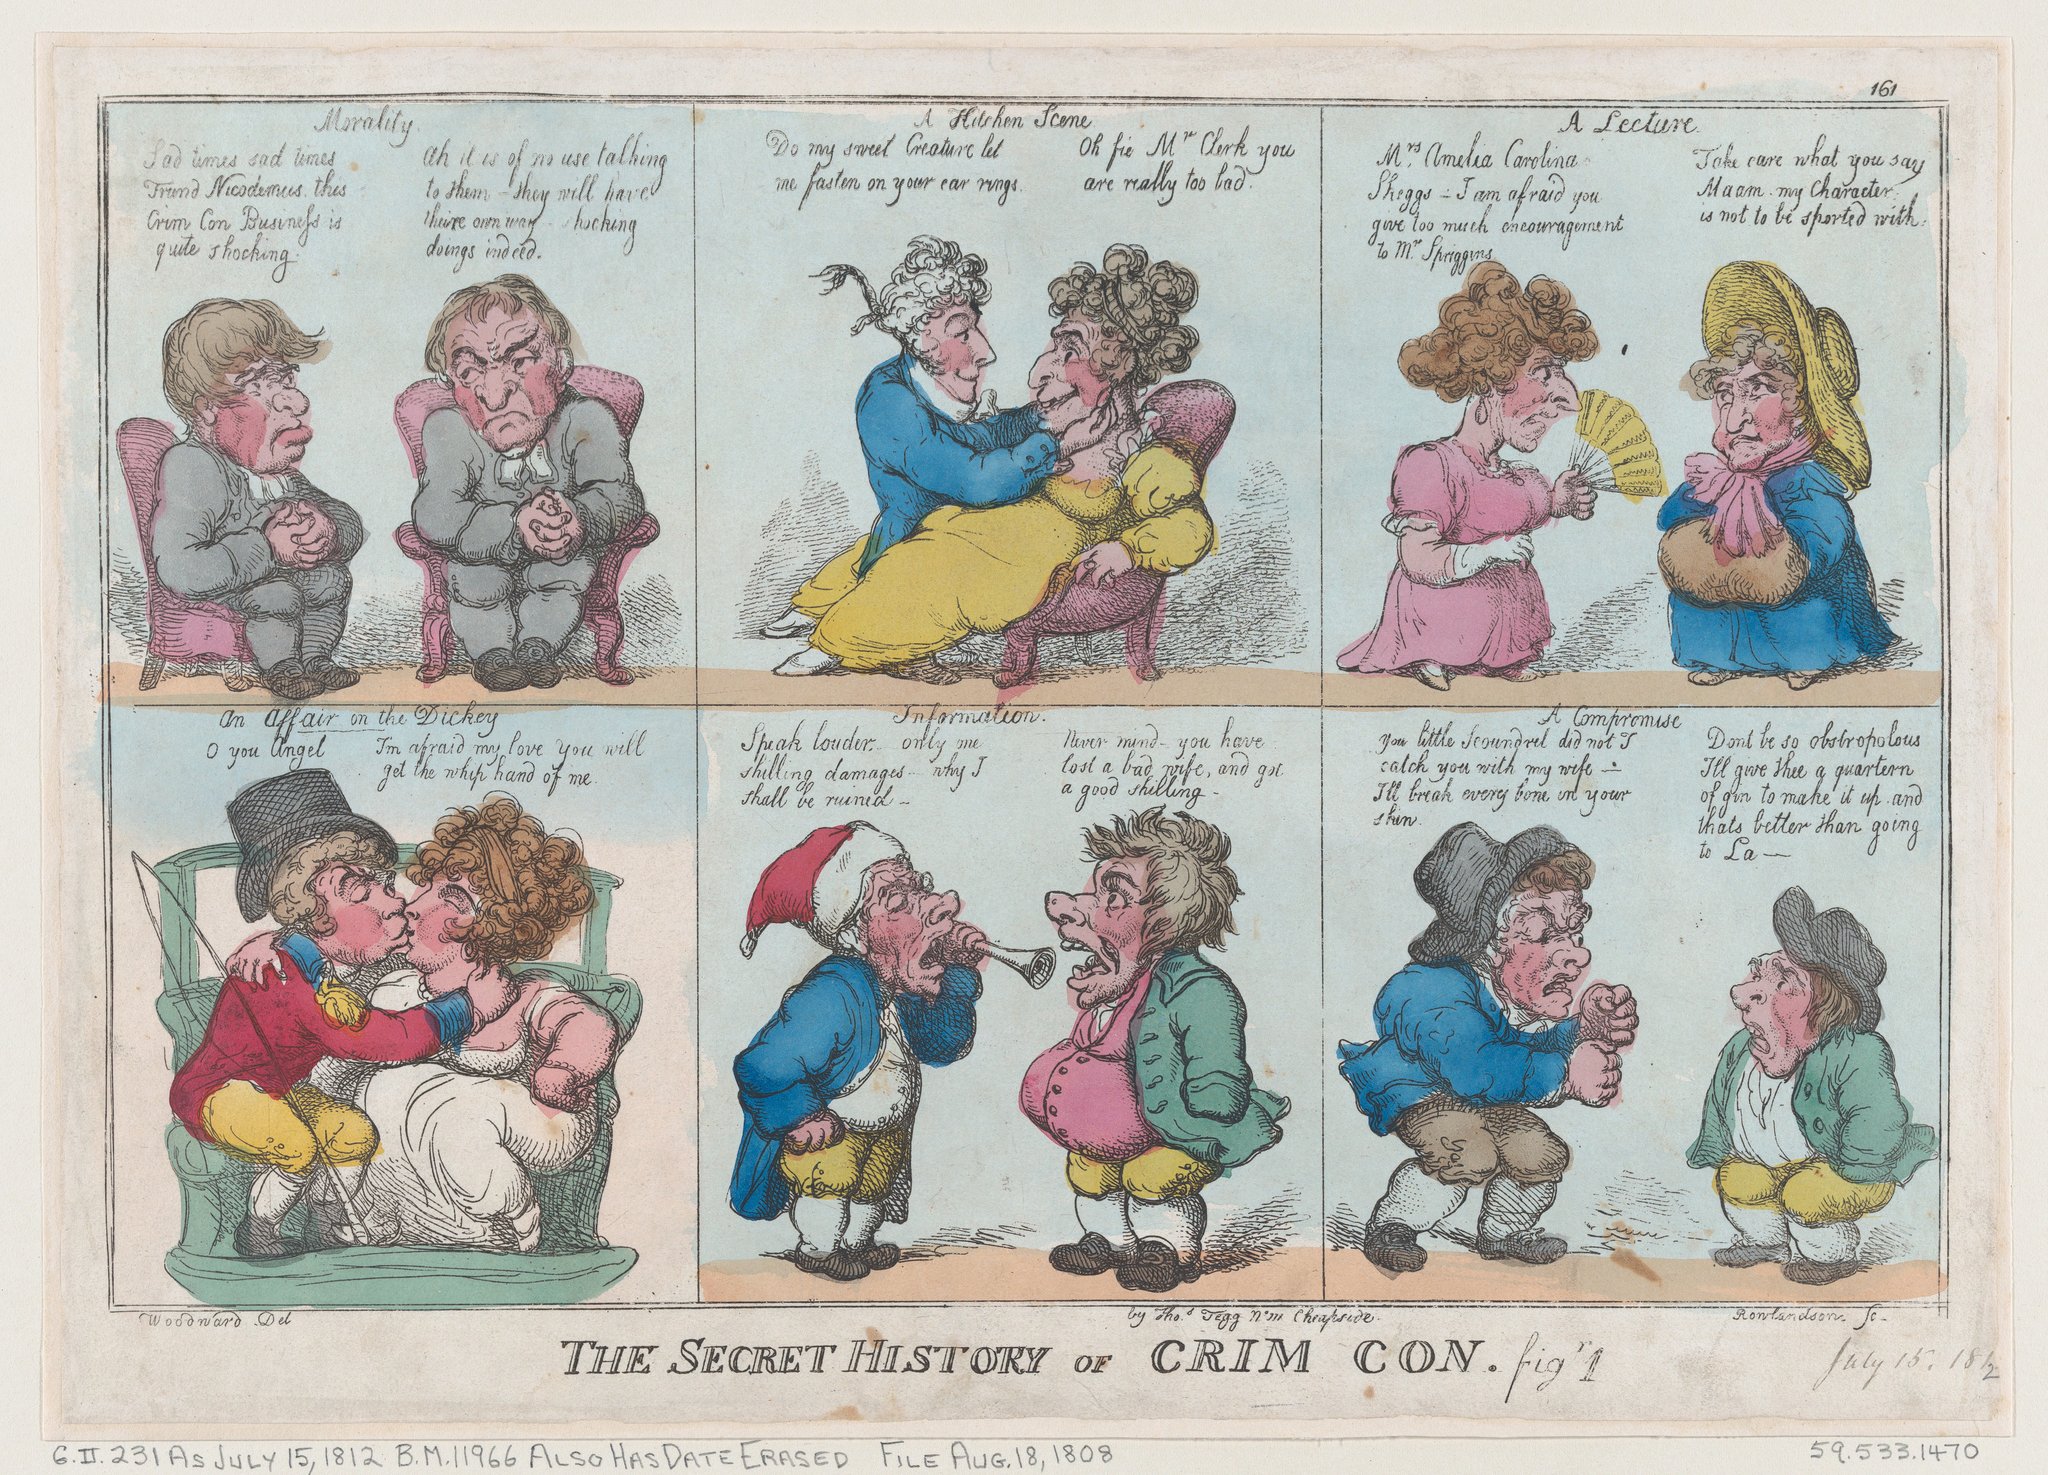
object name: print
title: The Secret History of Crim Con, Fig 1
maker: thomas rowlandson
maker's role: artist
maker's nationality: british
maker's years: 1757-1827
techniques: etching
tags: satire,men,women